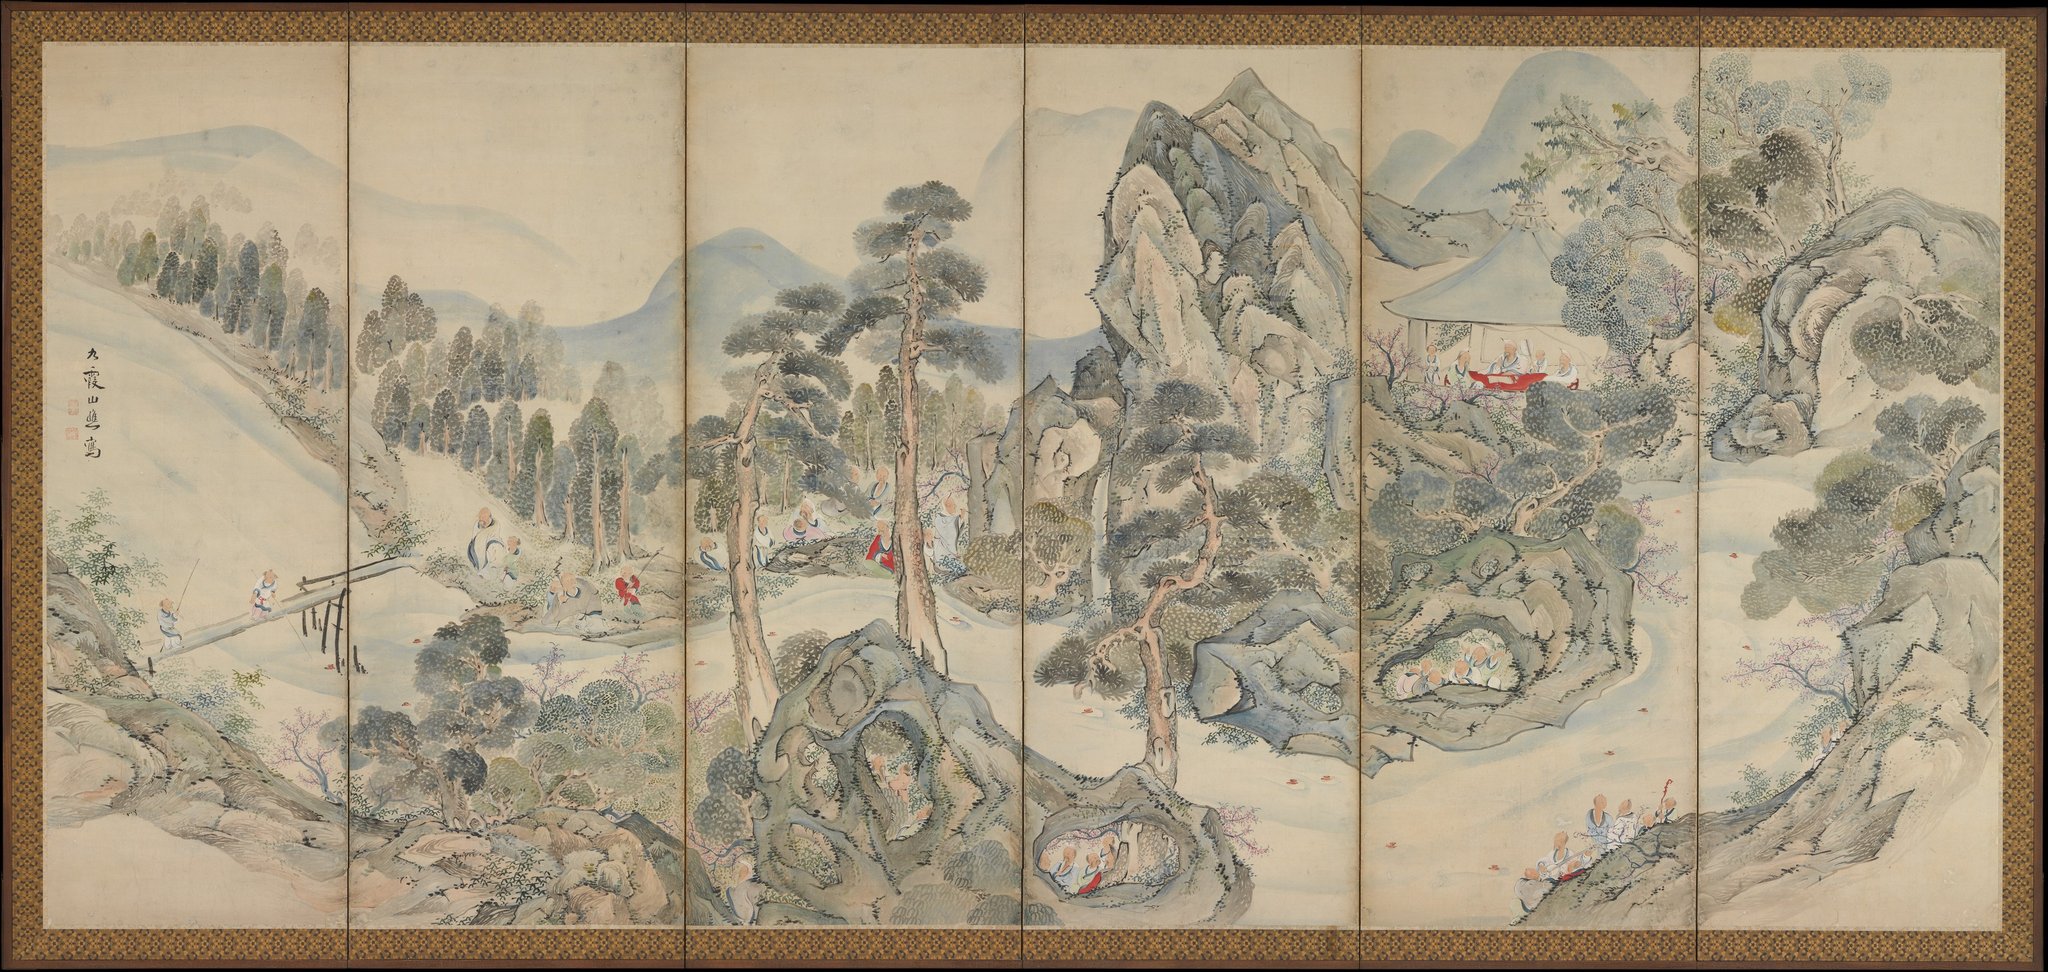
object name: screen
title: Orchid Pavilion Gathering; Autumn Harvest Festival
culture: japanese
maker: ike no taiga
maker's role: artist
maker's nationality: japanese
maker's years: 1723-1776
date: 1763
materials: ink, panel, paper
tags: mountains,landscapes,trees,autumn